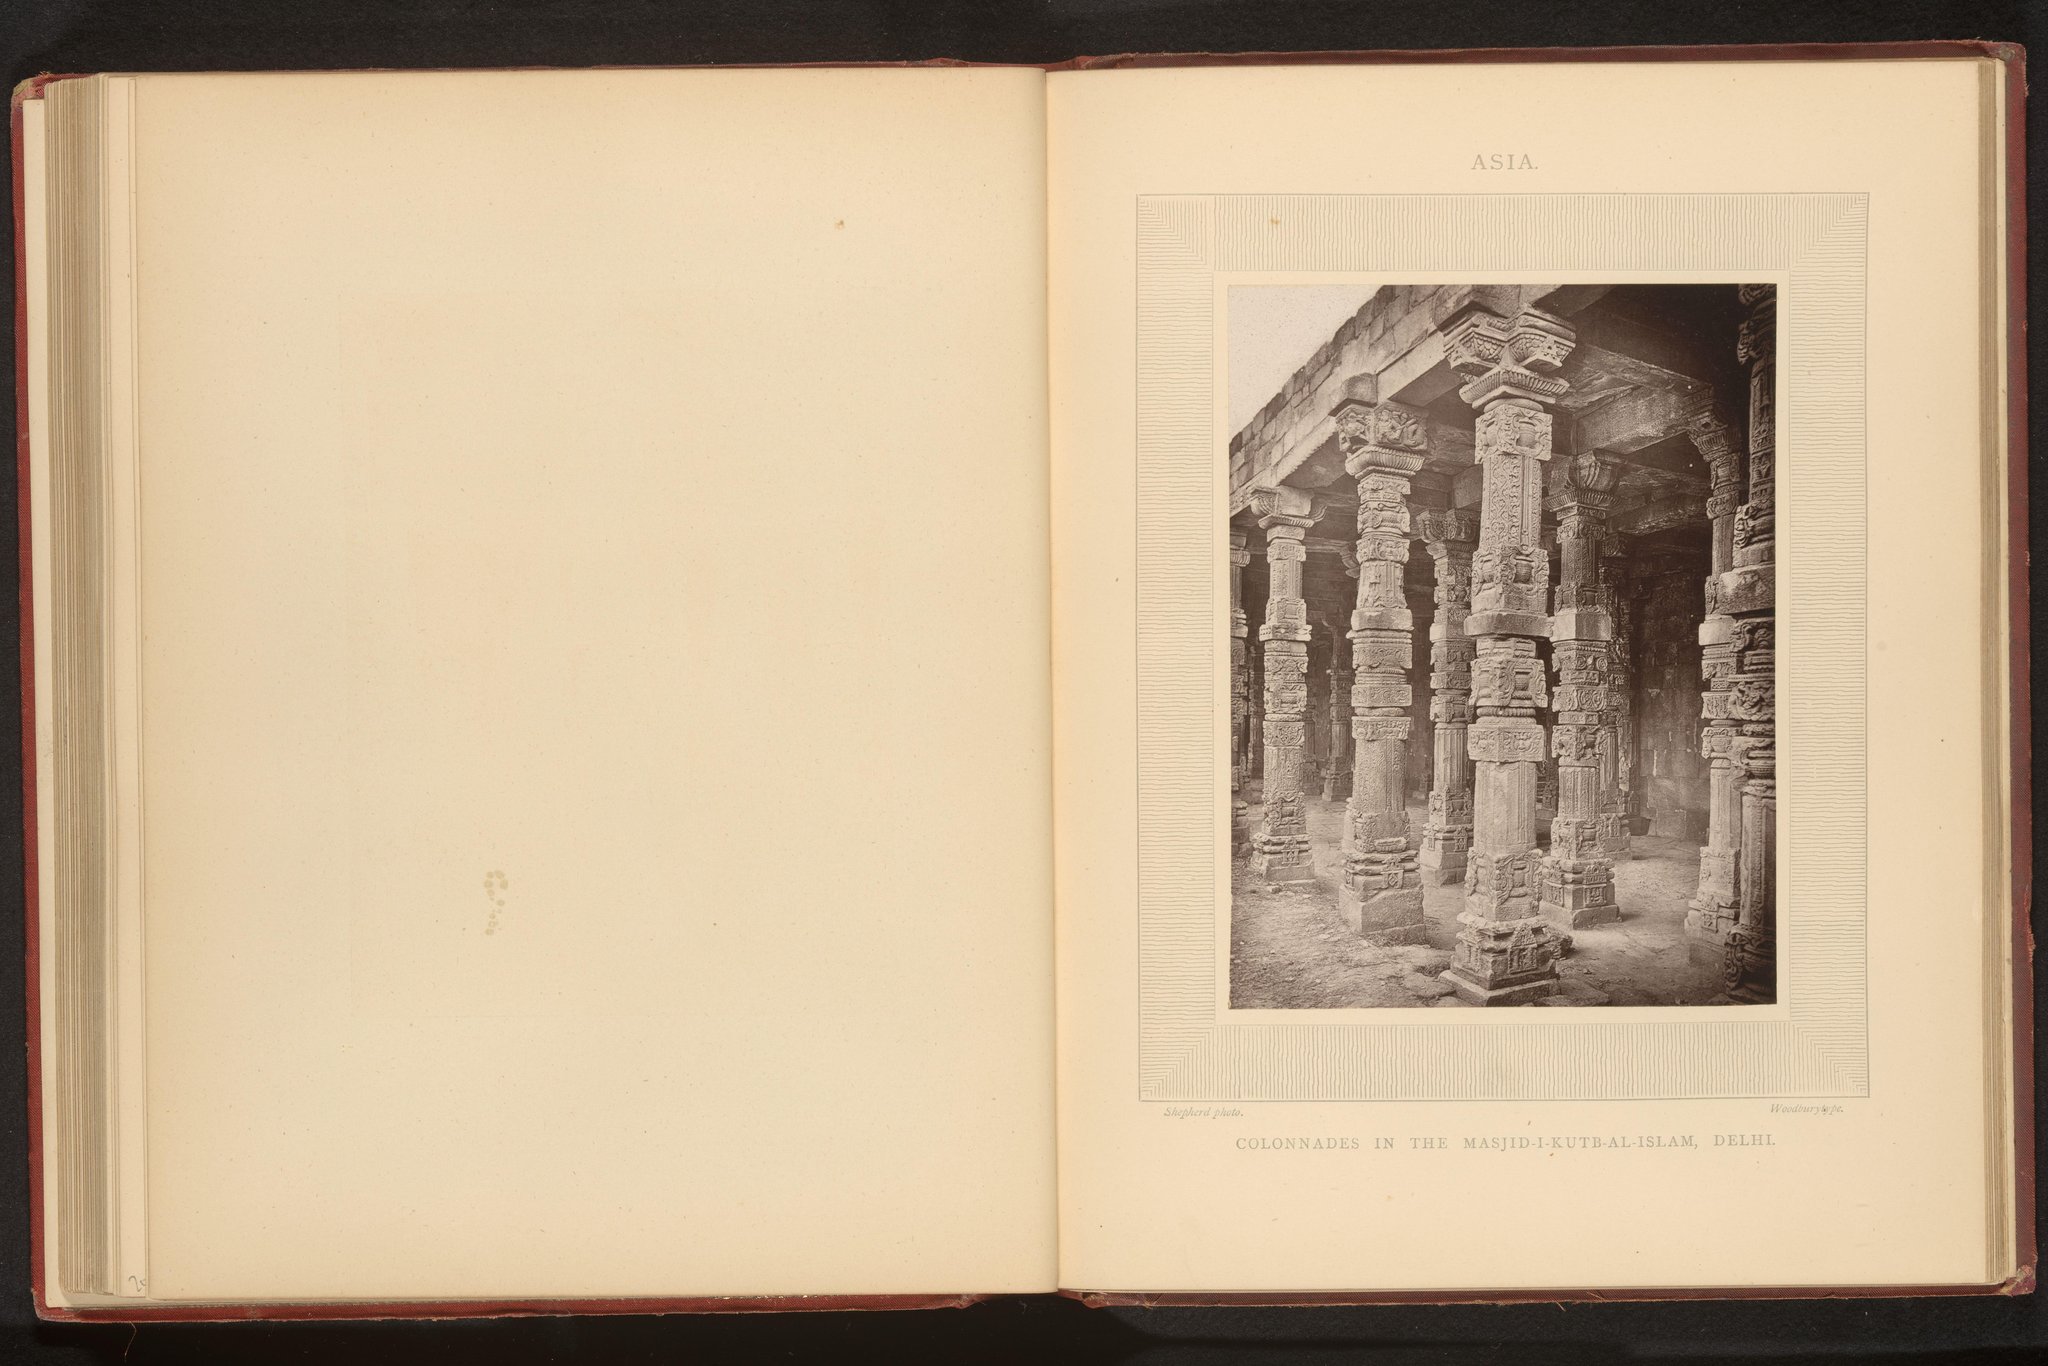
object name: photomechanical print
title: Colonnades in the Masjid-I-Kutb-al-Islam, Delhi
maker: george sidney shepherd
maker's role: painter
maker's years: 1784-1862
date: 1870-1875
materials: cardboard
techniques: woodburytype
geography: qutb-complex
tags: colonnade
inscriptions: inscription: ‘Asia’